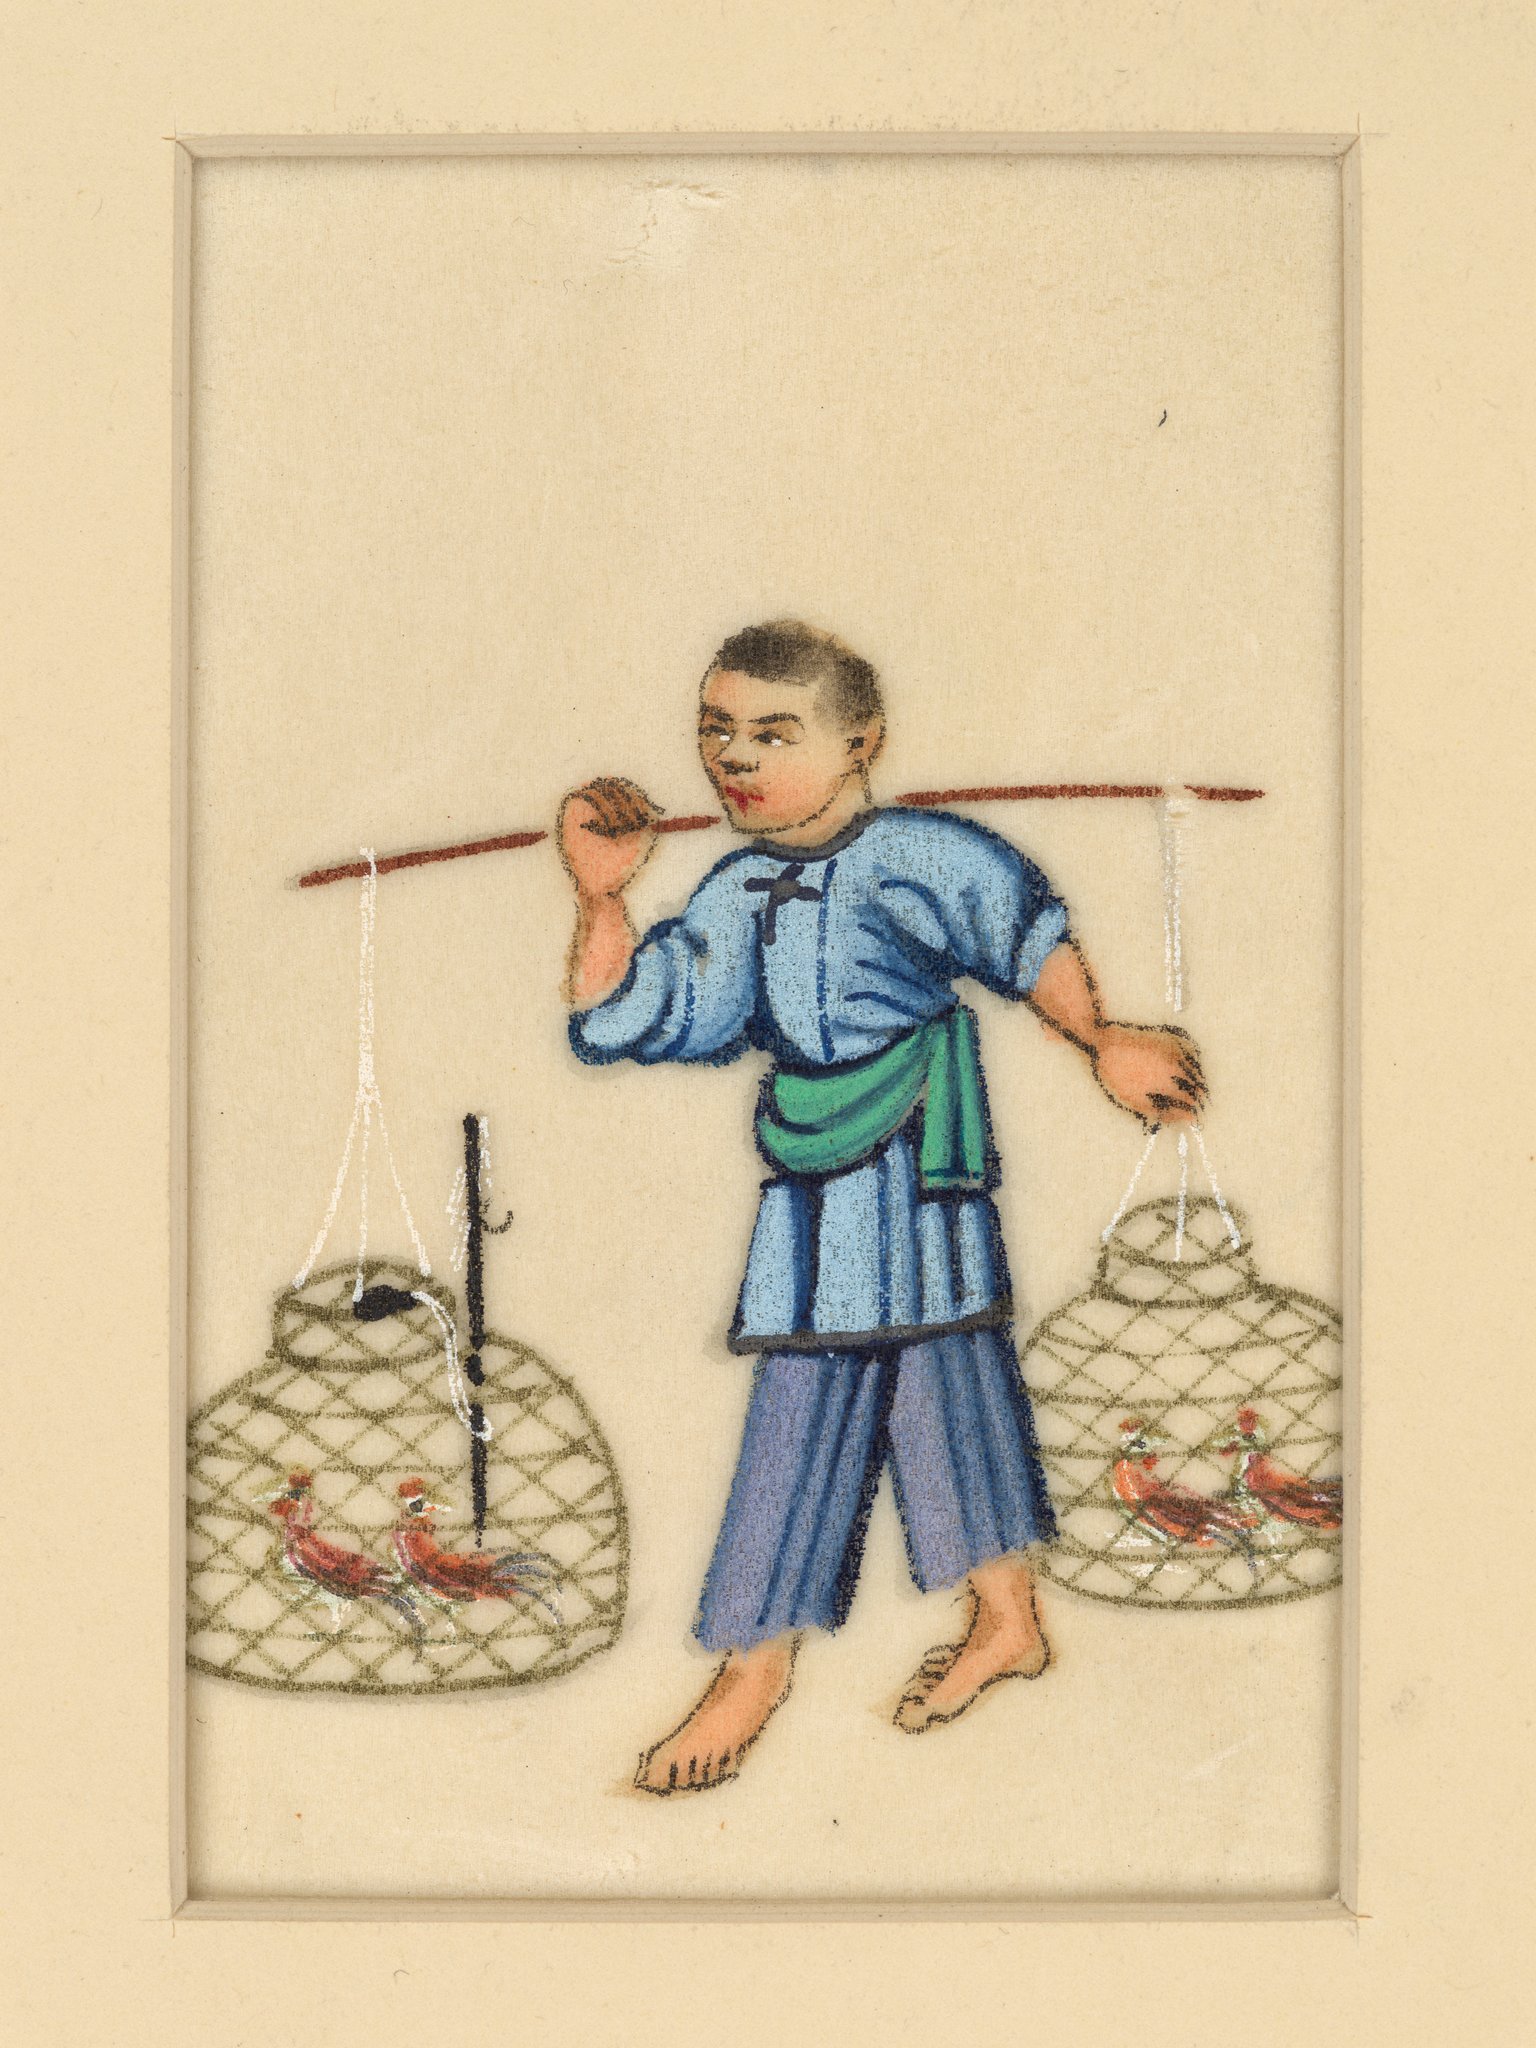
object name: leaf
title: Bamboo (?) Vendor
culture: chinese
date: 1901-1933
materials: paper